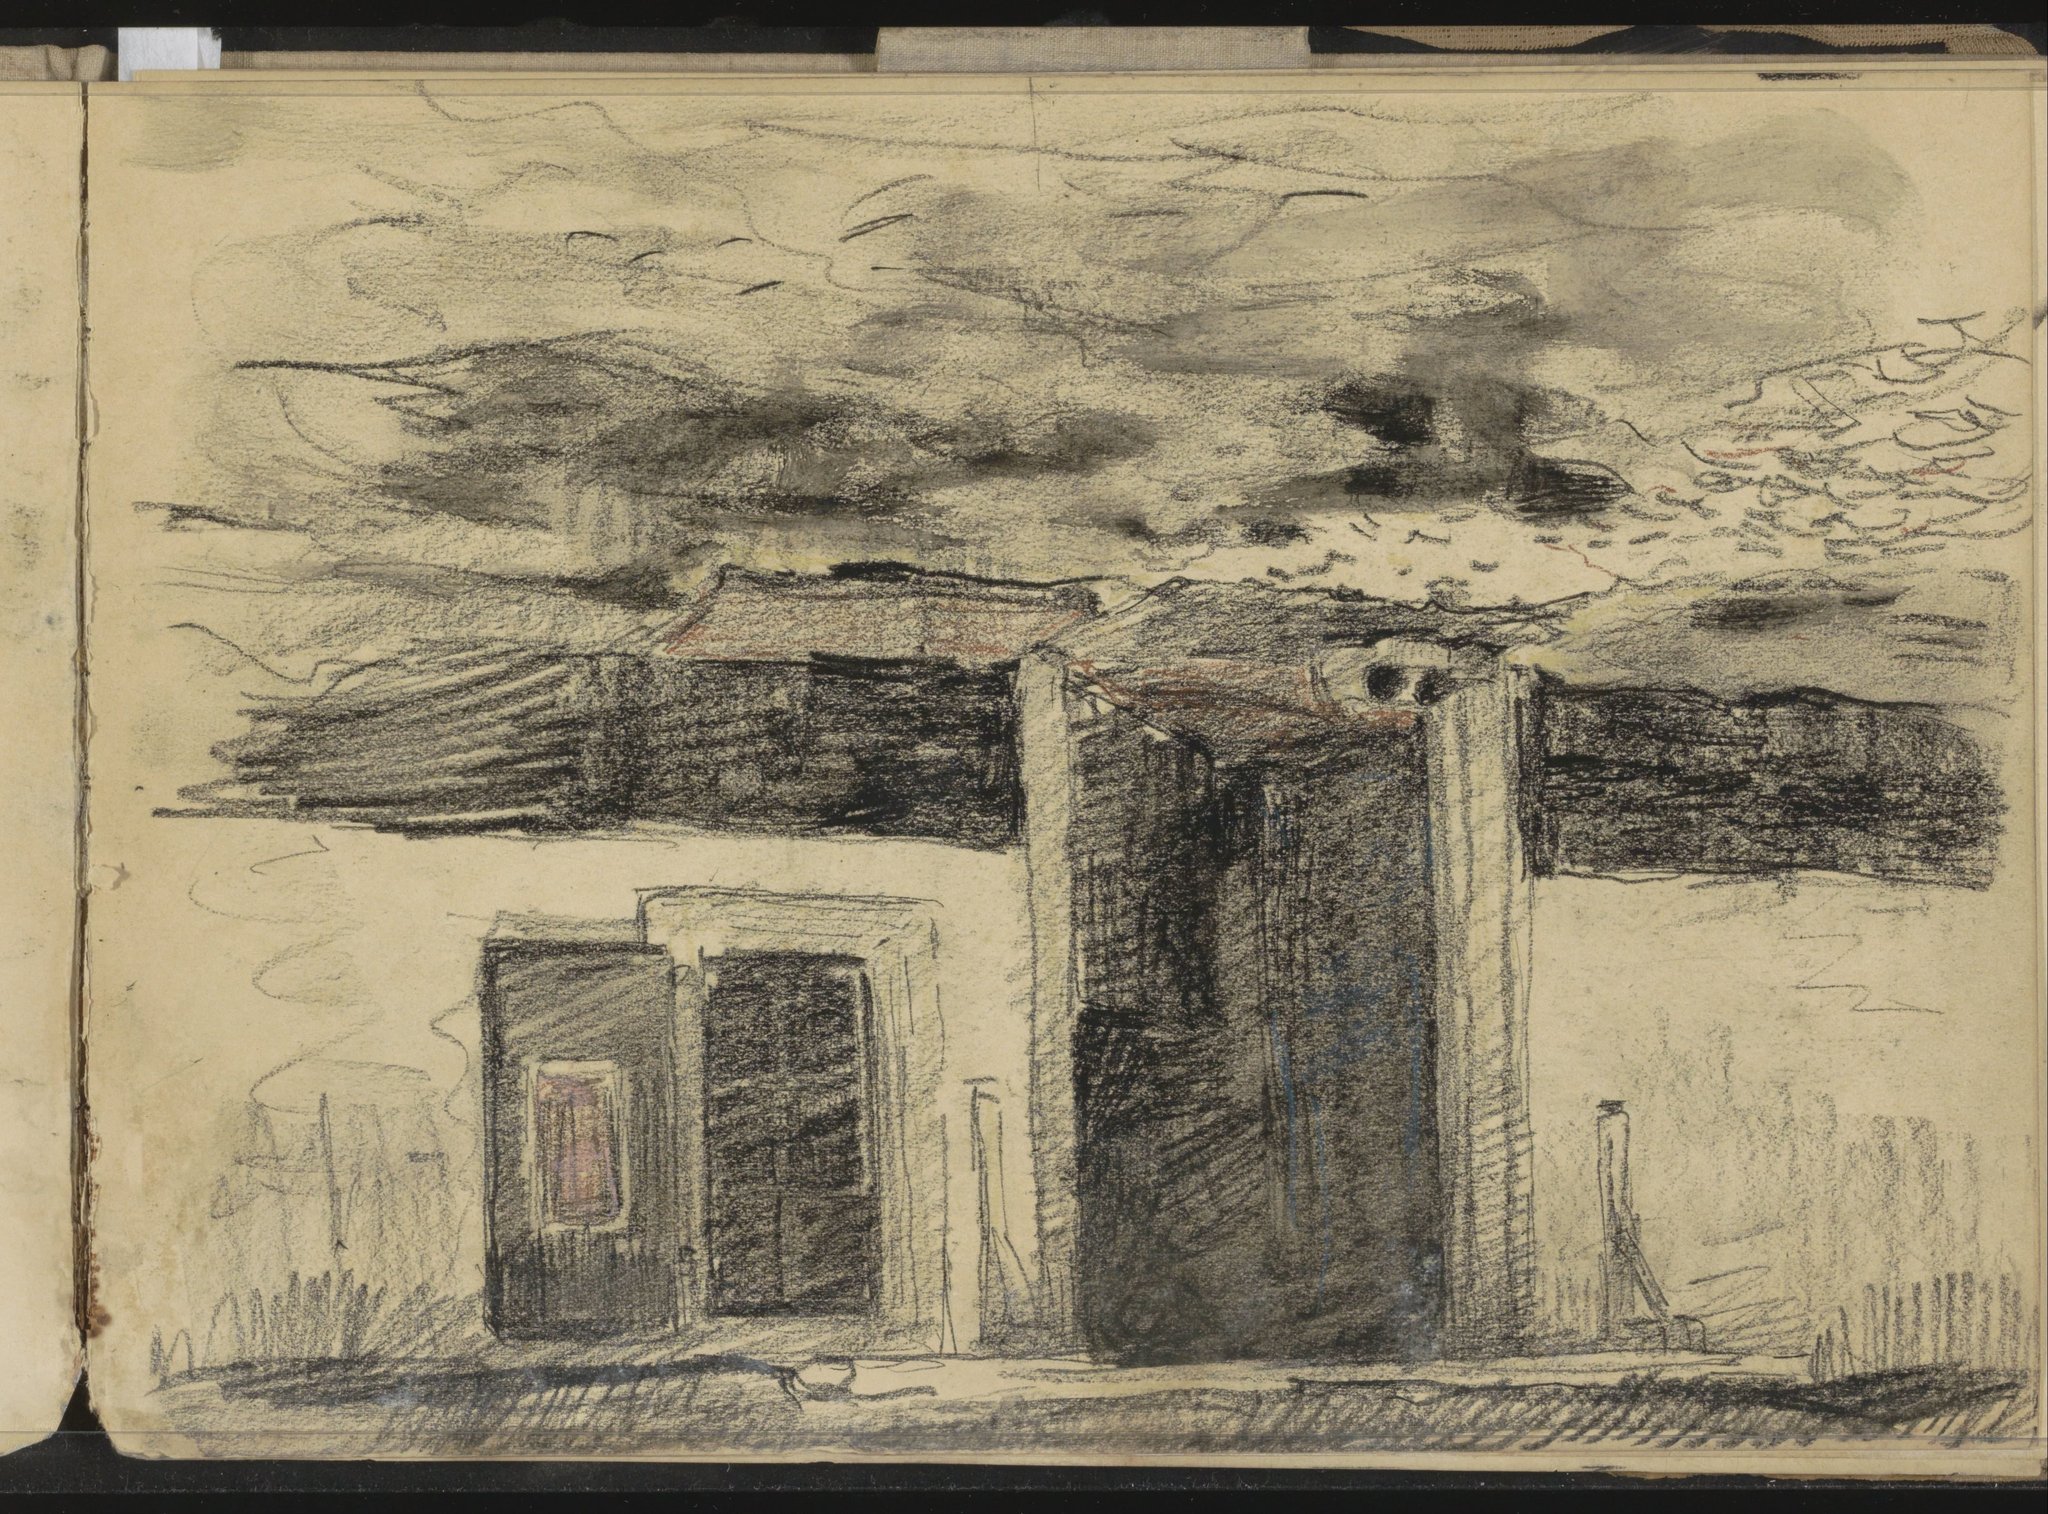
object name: sketchbook leaf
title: Huis met luiken, mogelijk een buitenhuis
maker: willem bastiaan tholen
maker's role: draughtsman, painter, print maker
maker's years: 1860-1931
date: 1885-1931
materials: chalk, paper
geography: lage vuursche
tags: window shutters on the outside, rural housing, e.g. country-house, villa, cottage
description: Mogelijk een huis op het landgoed Ewijckshoeve. Blad 5 recto uit een schetsboek met 28 bladen.